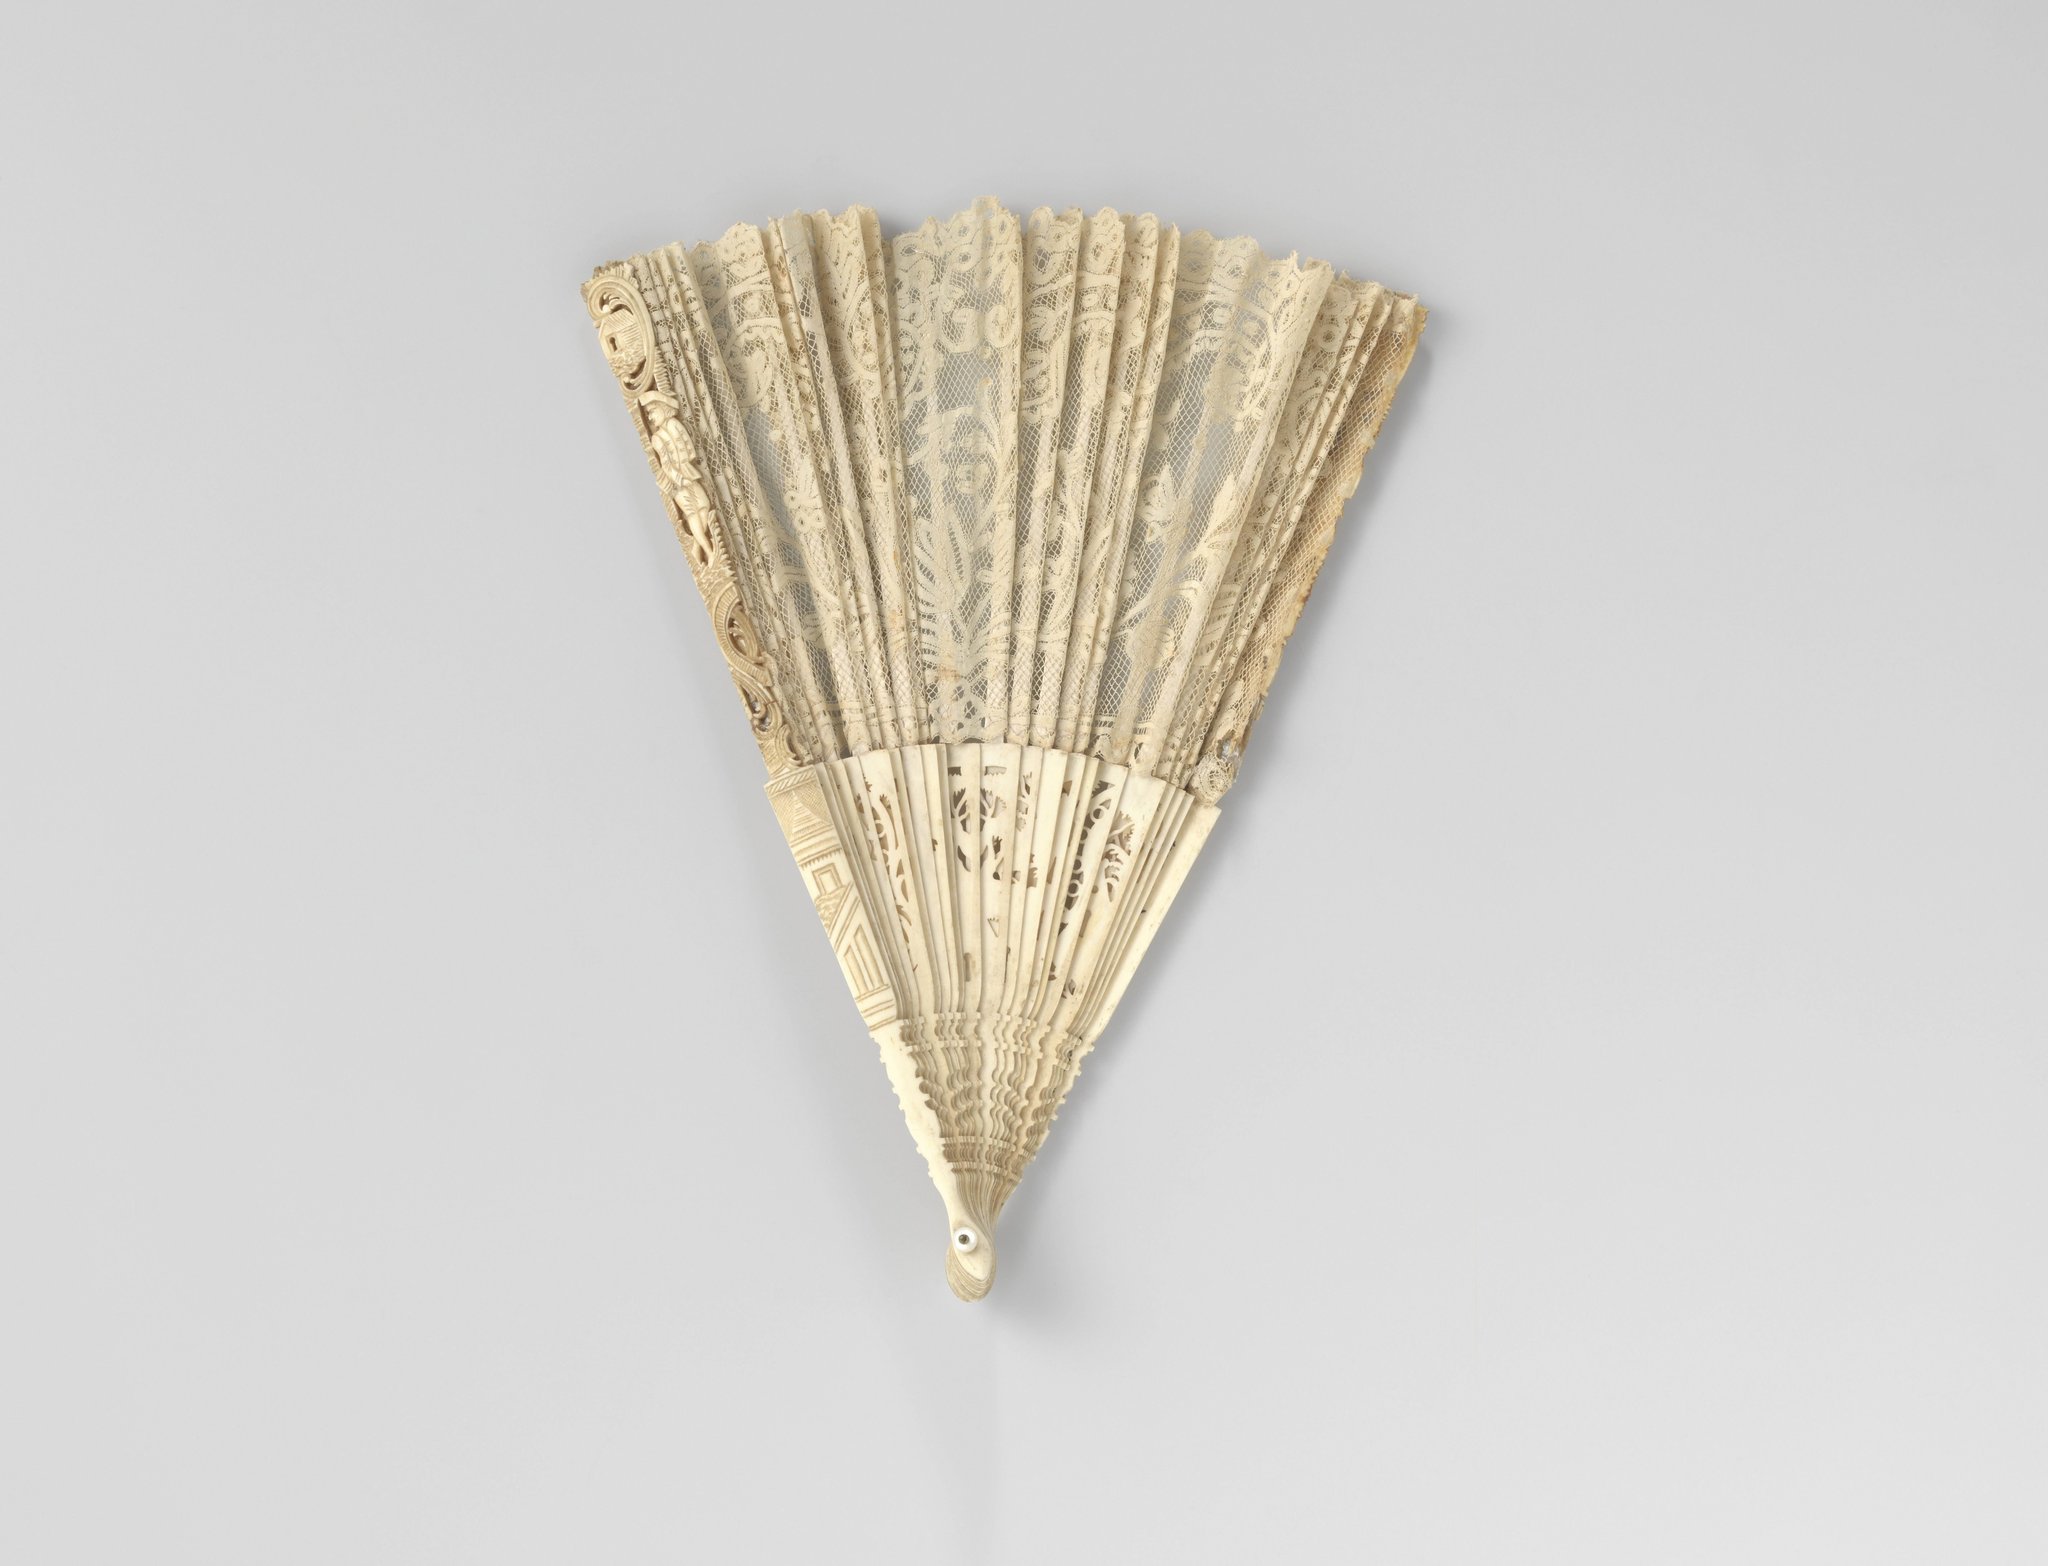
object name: vouwwaaier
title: Vouwwaaier met blad van kloskant (Valenciennes) op een montuur van gesneden ivoor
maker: Anonymous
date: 1725-1775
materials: iron, ivory, mother of pearl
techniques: cutting, lace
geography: france